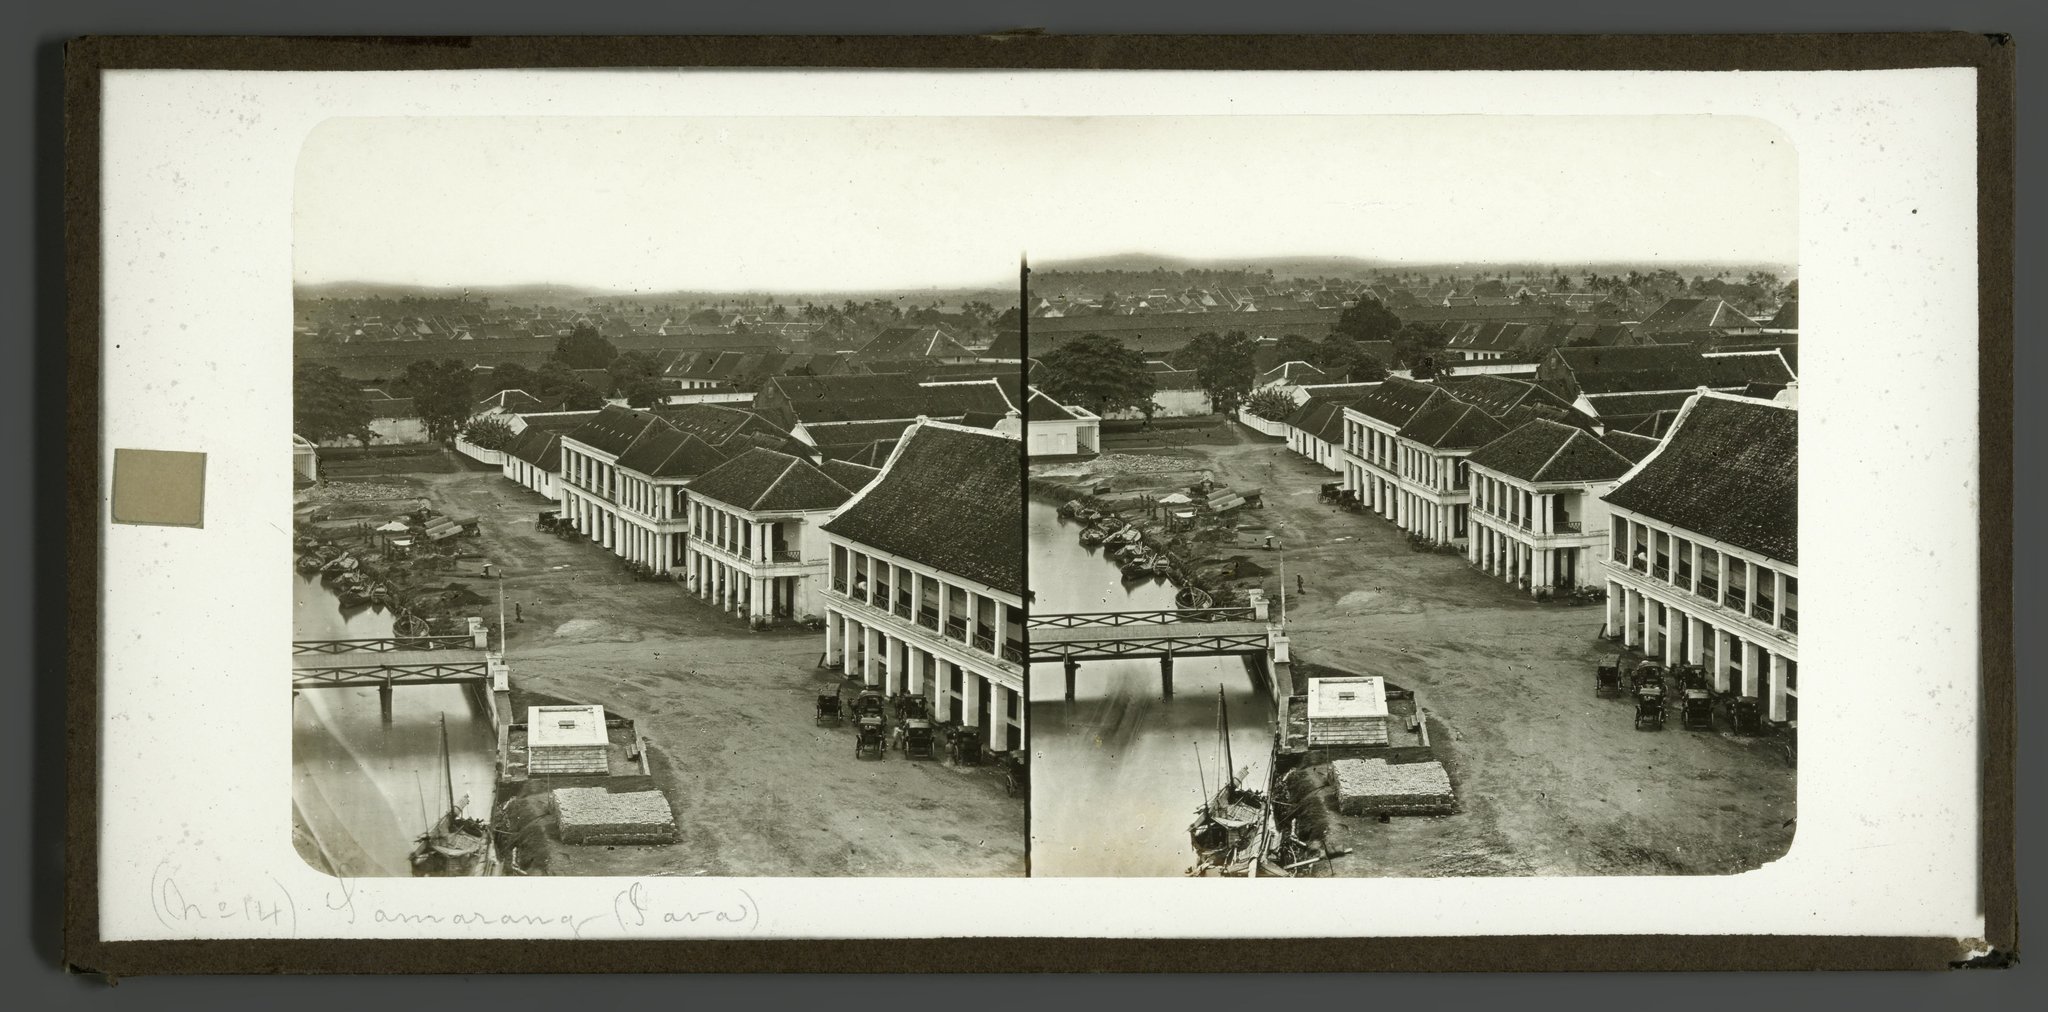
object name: photograph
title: Samarang (Java)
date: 1857-1864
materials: glass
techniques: slide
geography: semarang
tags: street